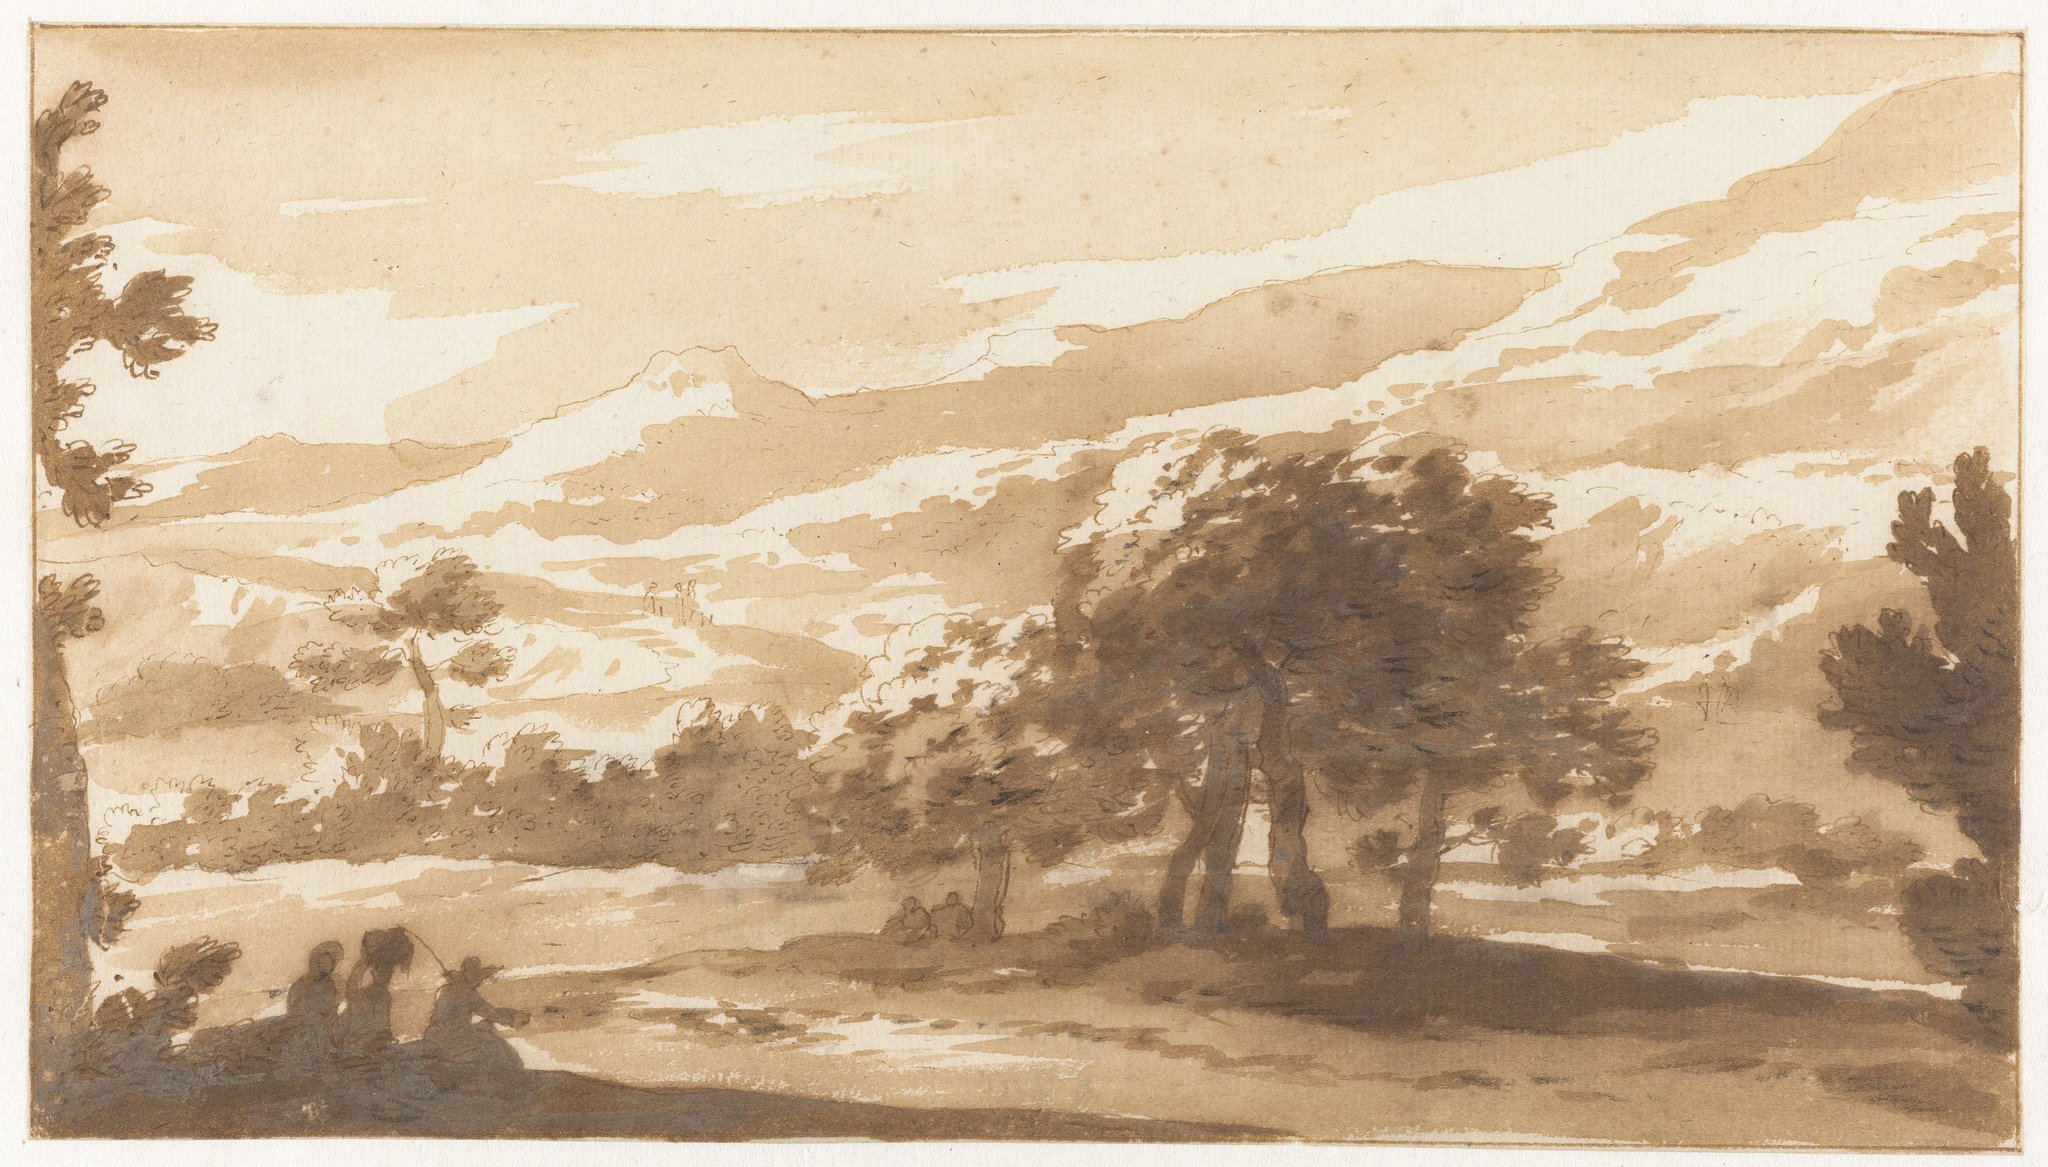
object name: drawing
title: Bergachtig landschap in Italië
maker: jan de bisschop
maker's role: draughtsman, print maker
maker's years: 1628-1671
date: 1648-1671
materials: ink, paper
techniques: brush, pen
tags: (high) hill, italy